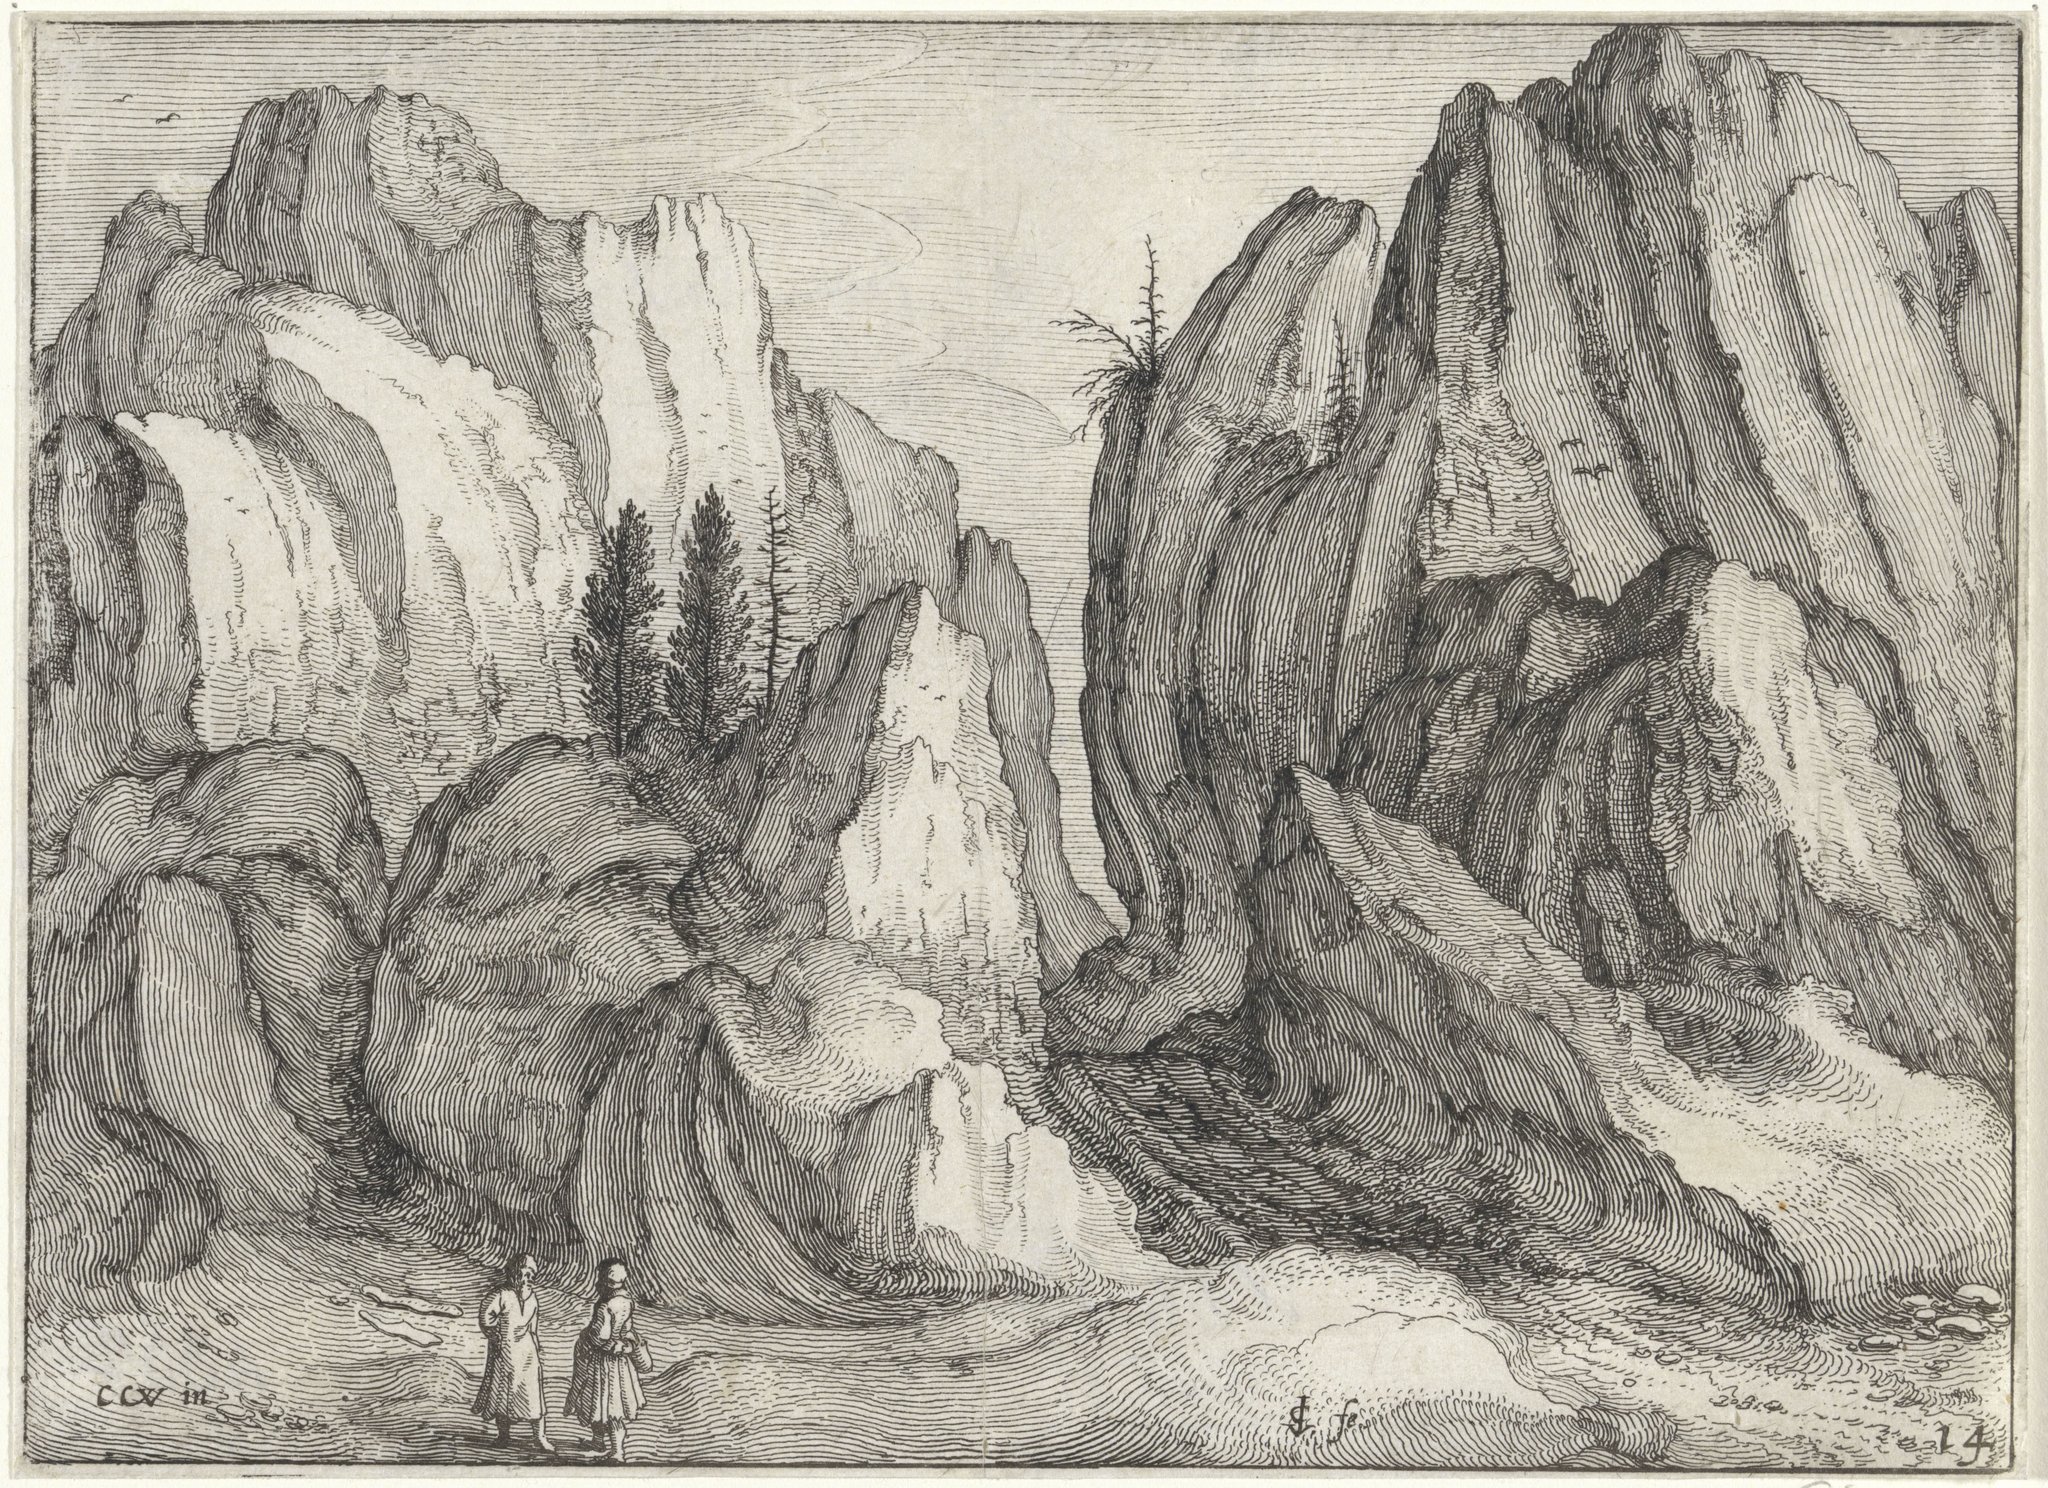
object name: print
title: Hollandse landschappen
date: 1613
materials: paper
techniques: etching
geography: amsterdam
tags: dale, valley, rocks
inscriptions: number: ‘14’, collector's mark: Lugt 2228, collector's mark: Lugt 1425, monogram: ‘CIV. fe’, monogram: ‘C CW in’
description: Gezicht in een vallei tussen rotsparijen. Op de voorgrond voeren twee mannen een gesprek.